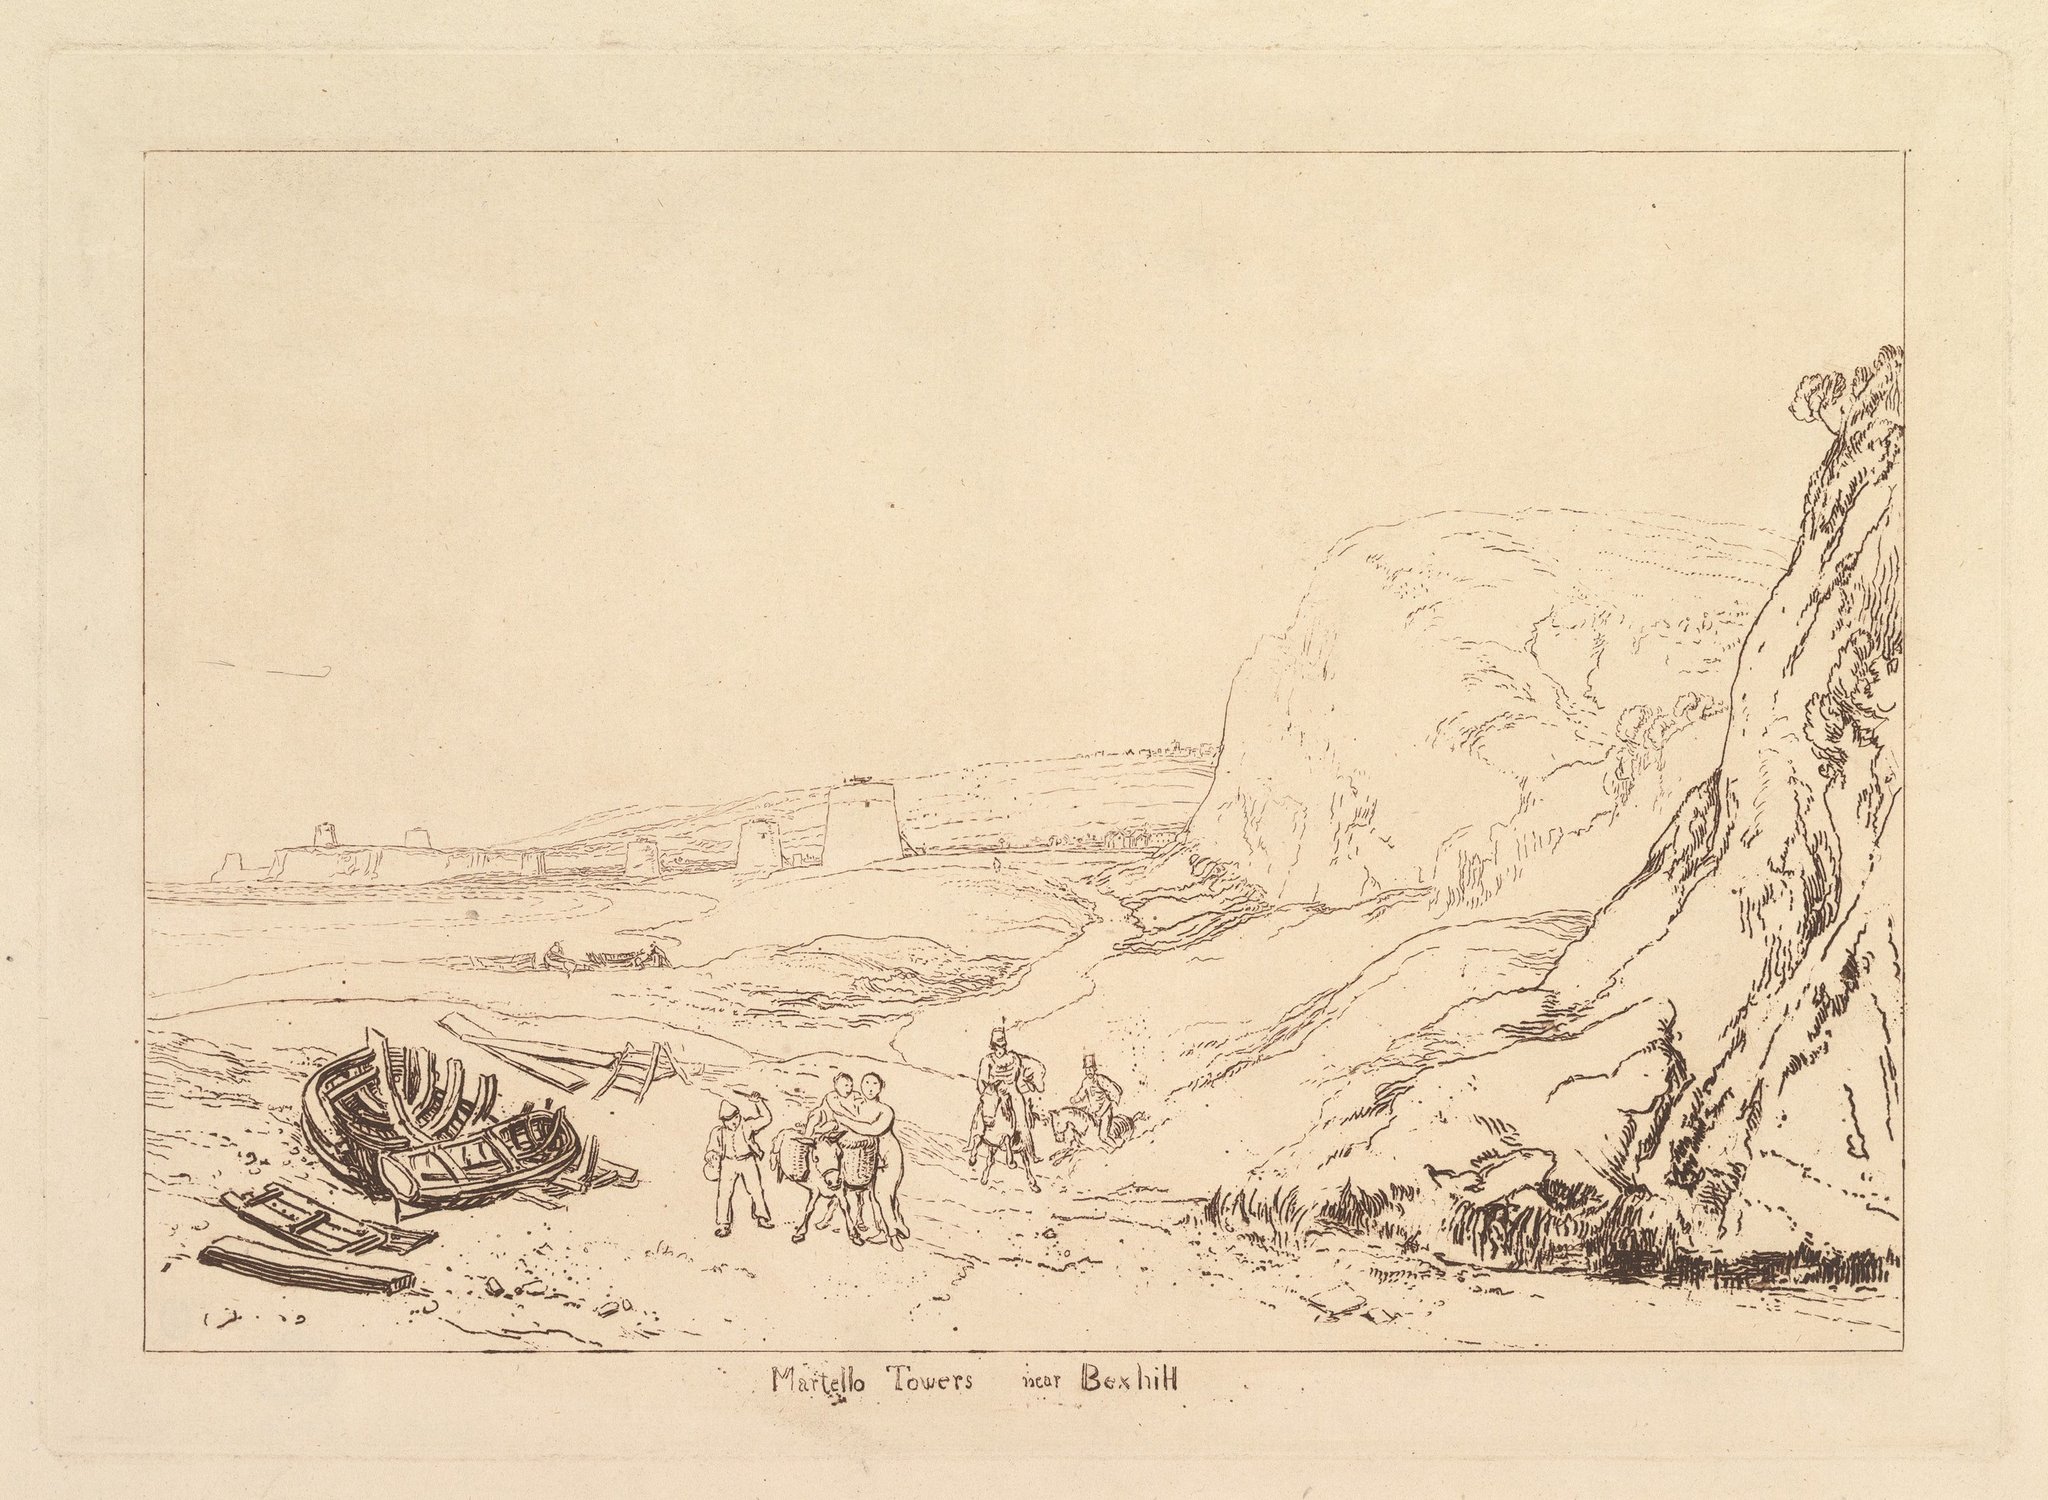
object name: print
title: Martello Towers near Bexhill, Sussex (Liber Studiorum, part VII, plate 34)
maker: joseph mallord william turner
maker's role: artist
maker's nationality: british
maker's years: 1775-1851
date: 1811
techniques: etching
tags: human figures,towers,landscapes